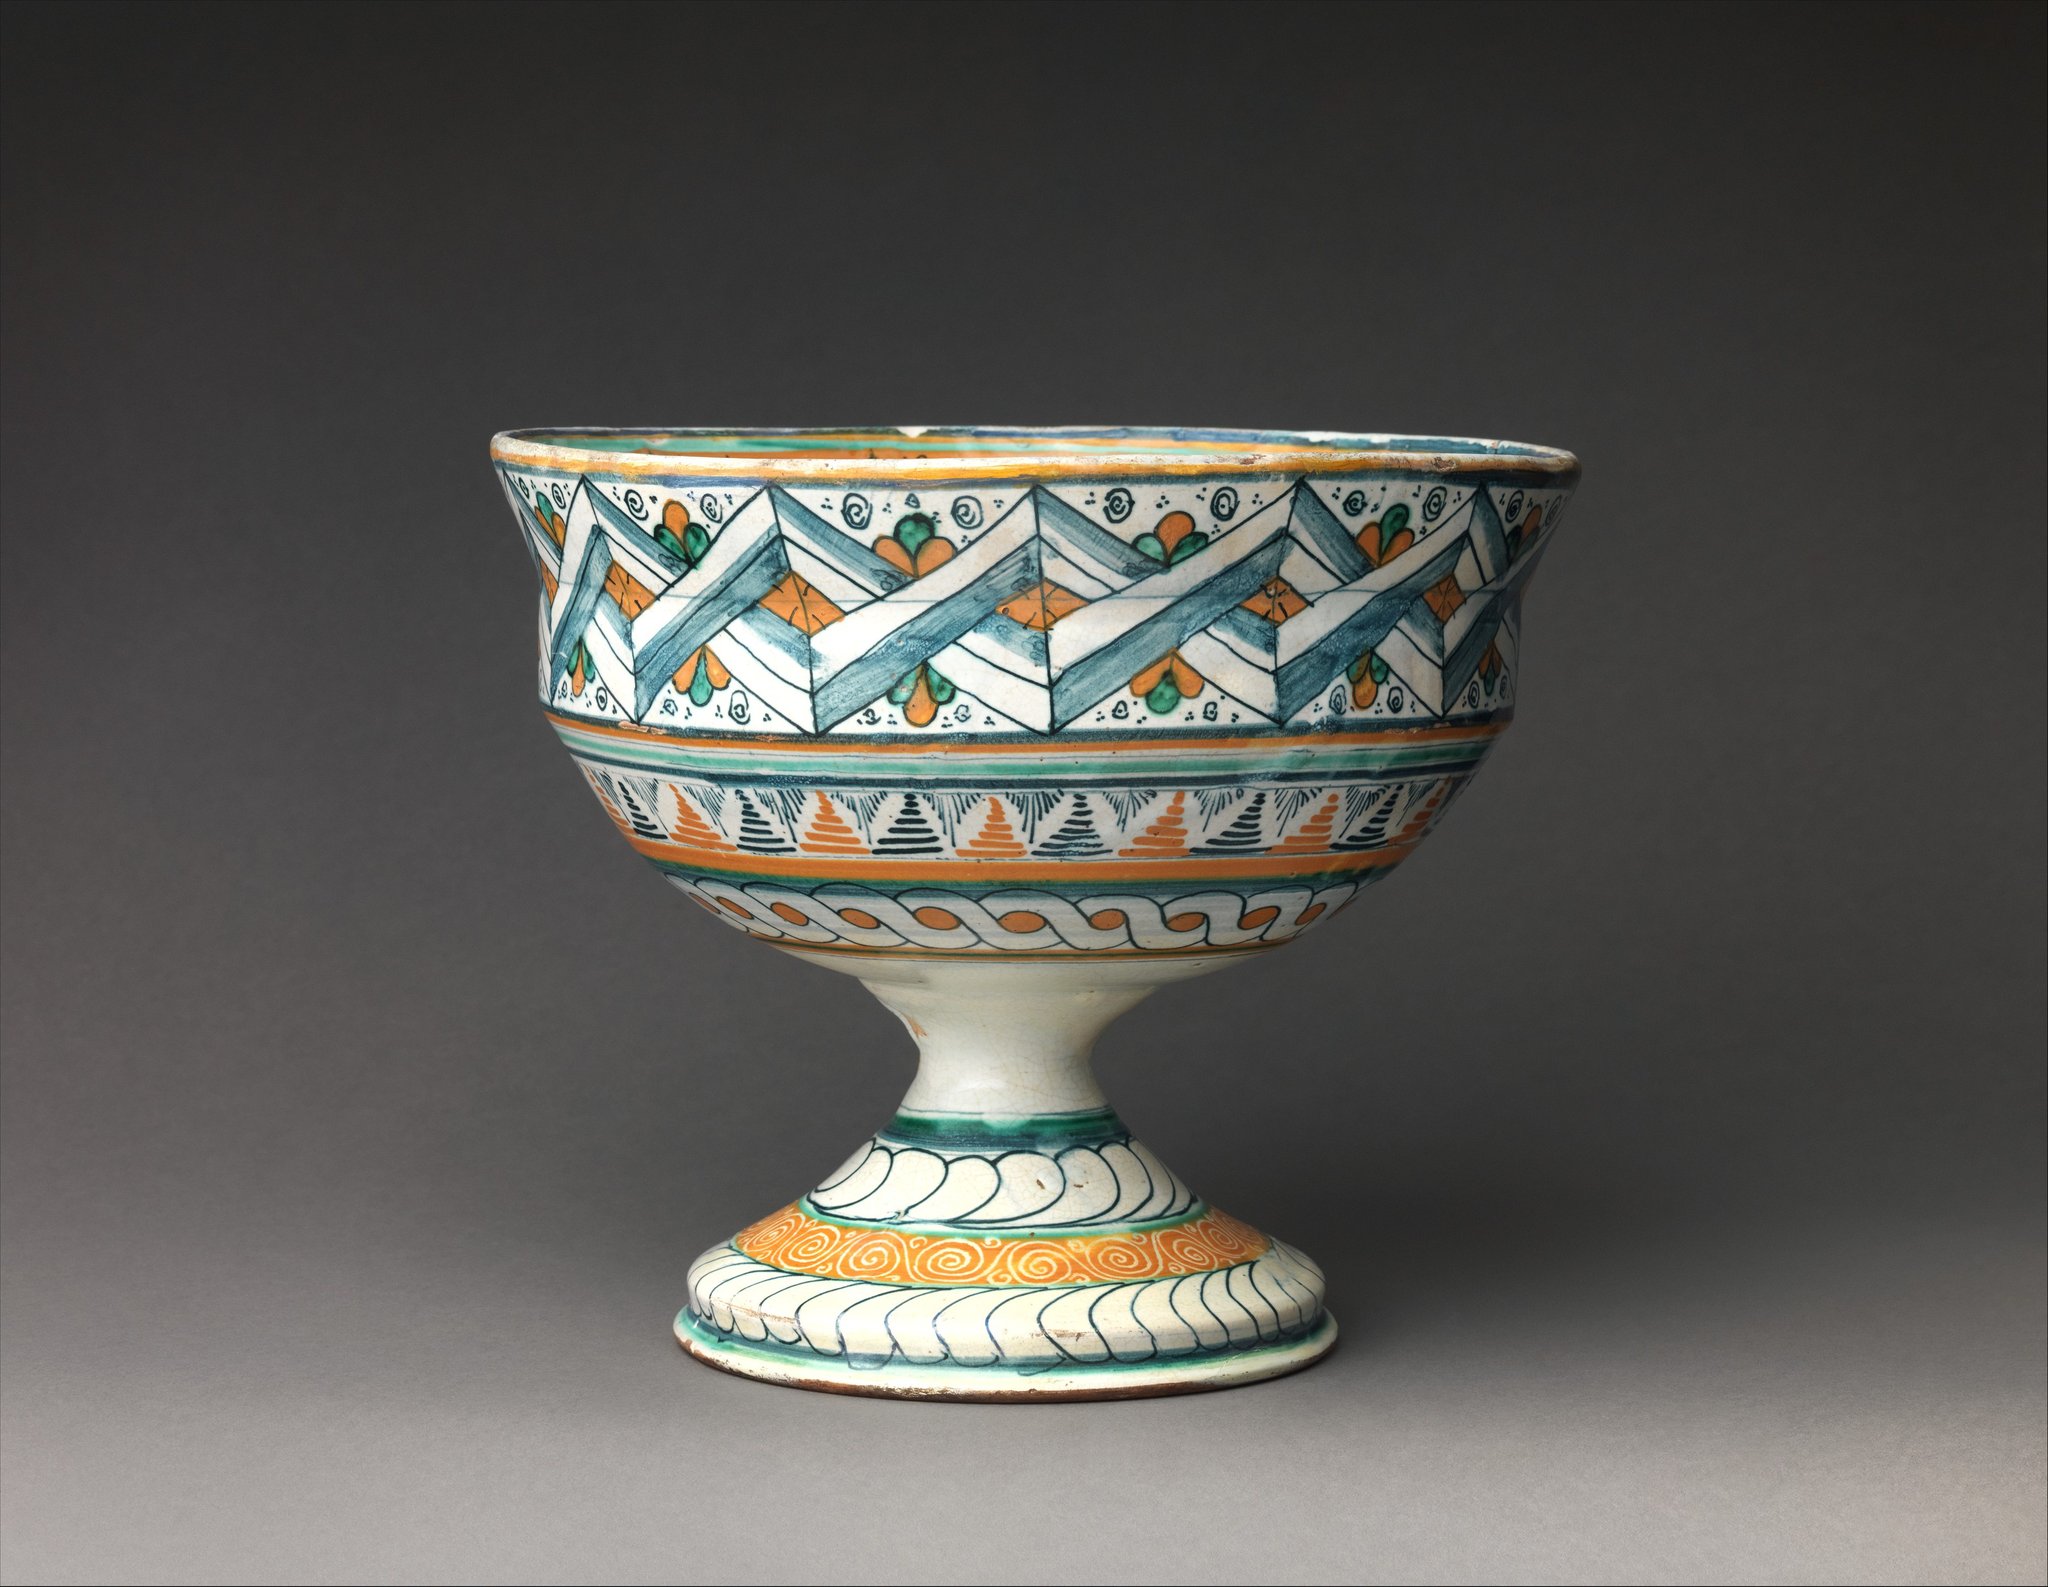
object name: footed bowl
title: Bowl with Lucretia Bella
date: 1480-1500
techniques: maiolica, glazing